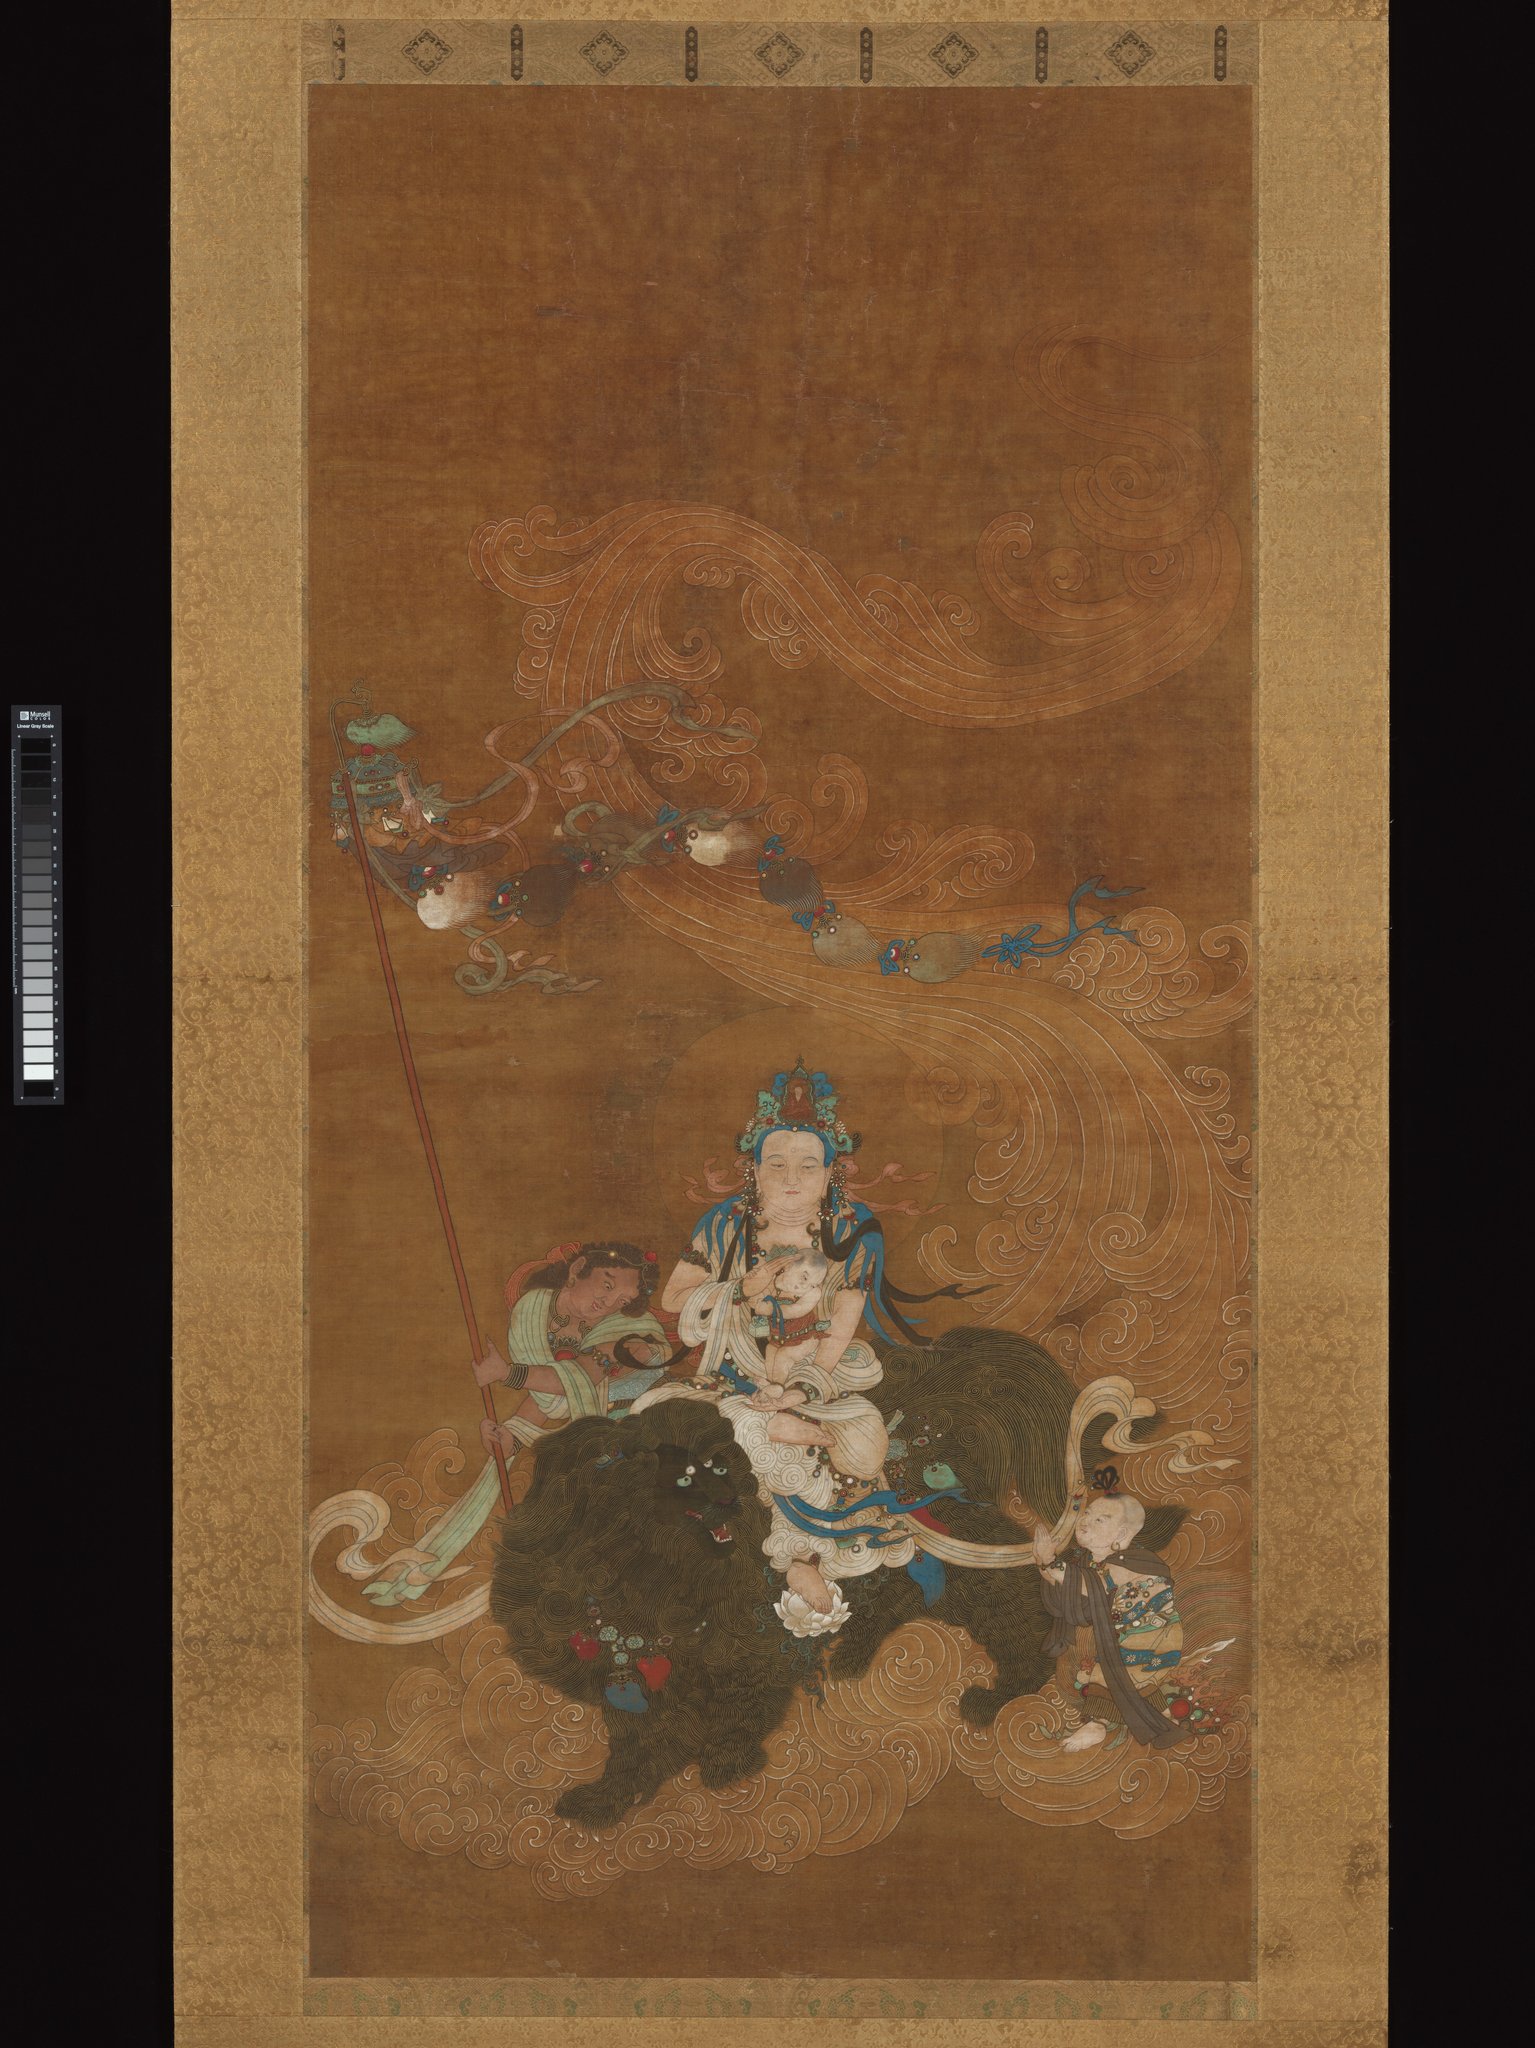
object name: hanging scroll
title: Guanyin the Bringer of Sons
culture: chinese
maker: unidentified artist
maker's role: artist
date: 1567-1600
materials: gold, ink, silk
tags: boys,infants,lions,bodhisattvas